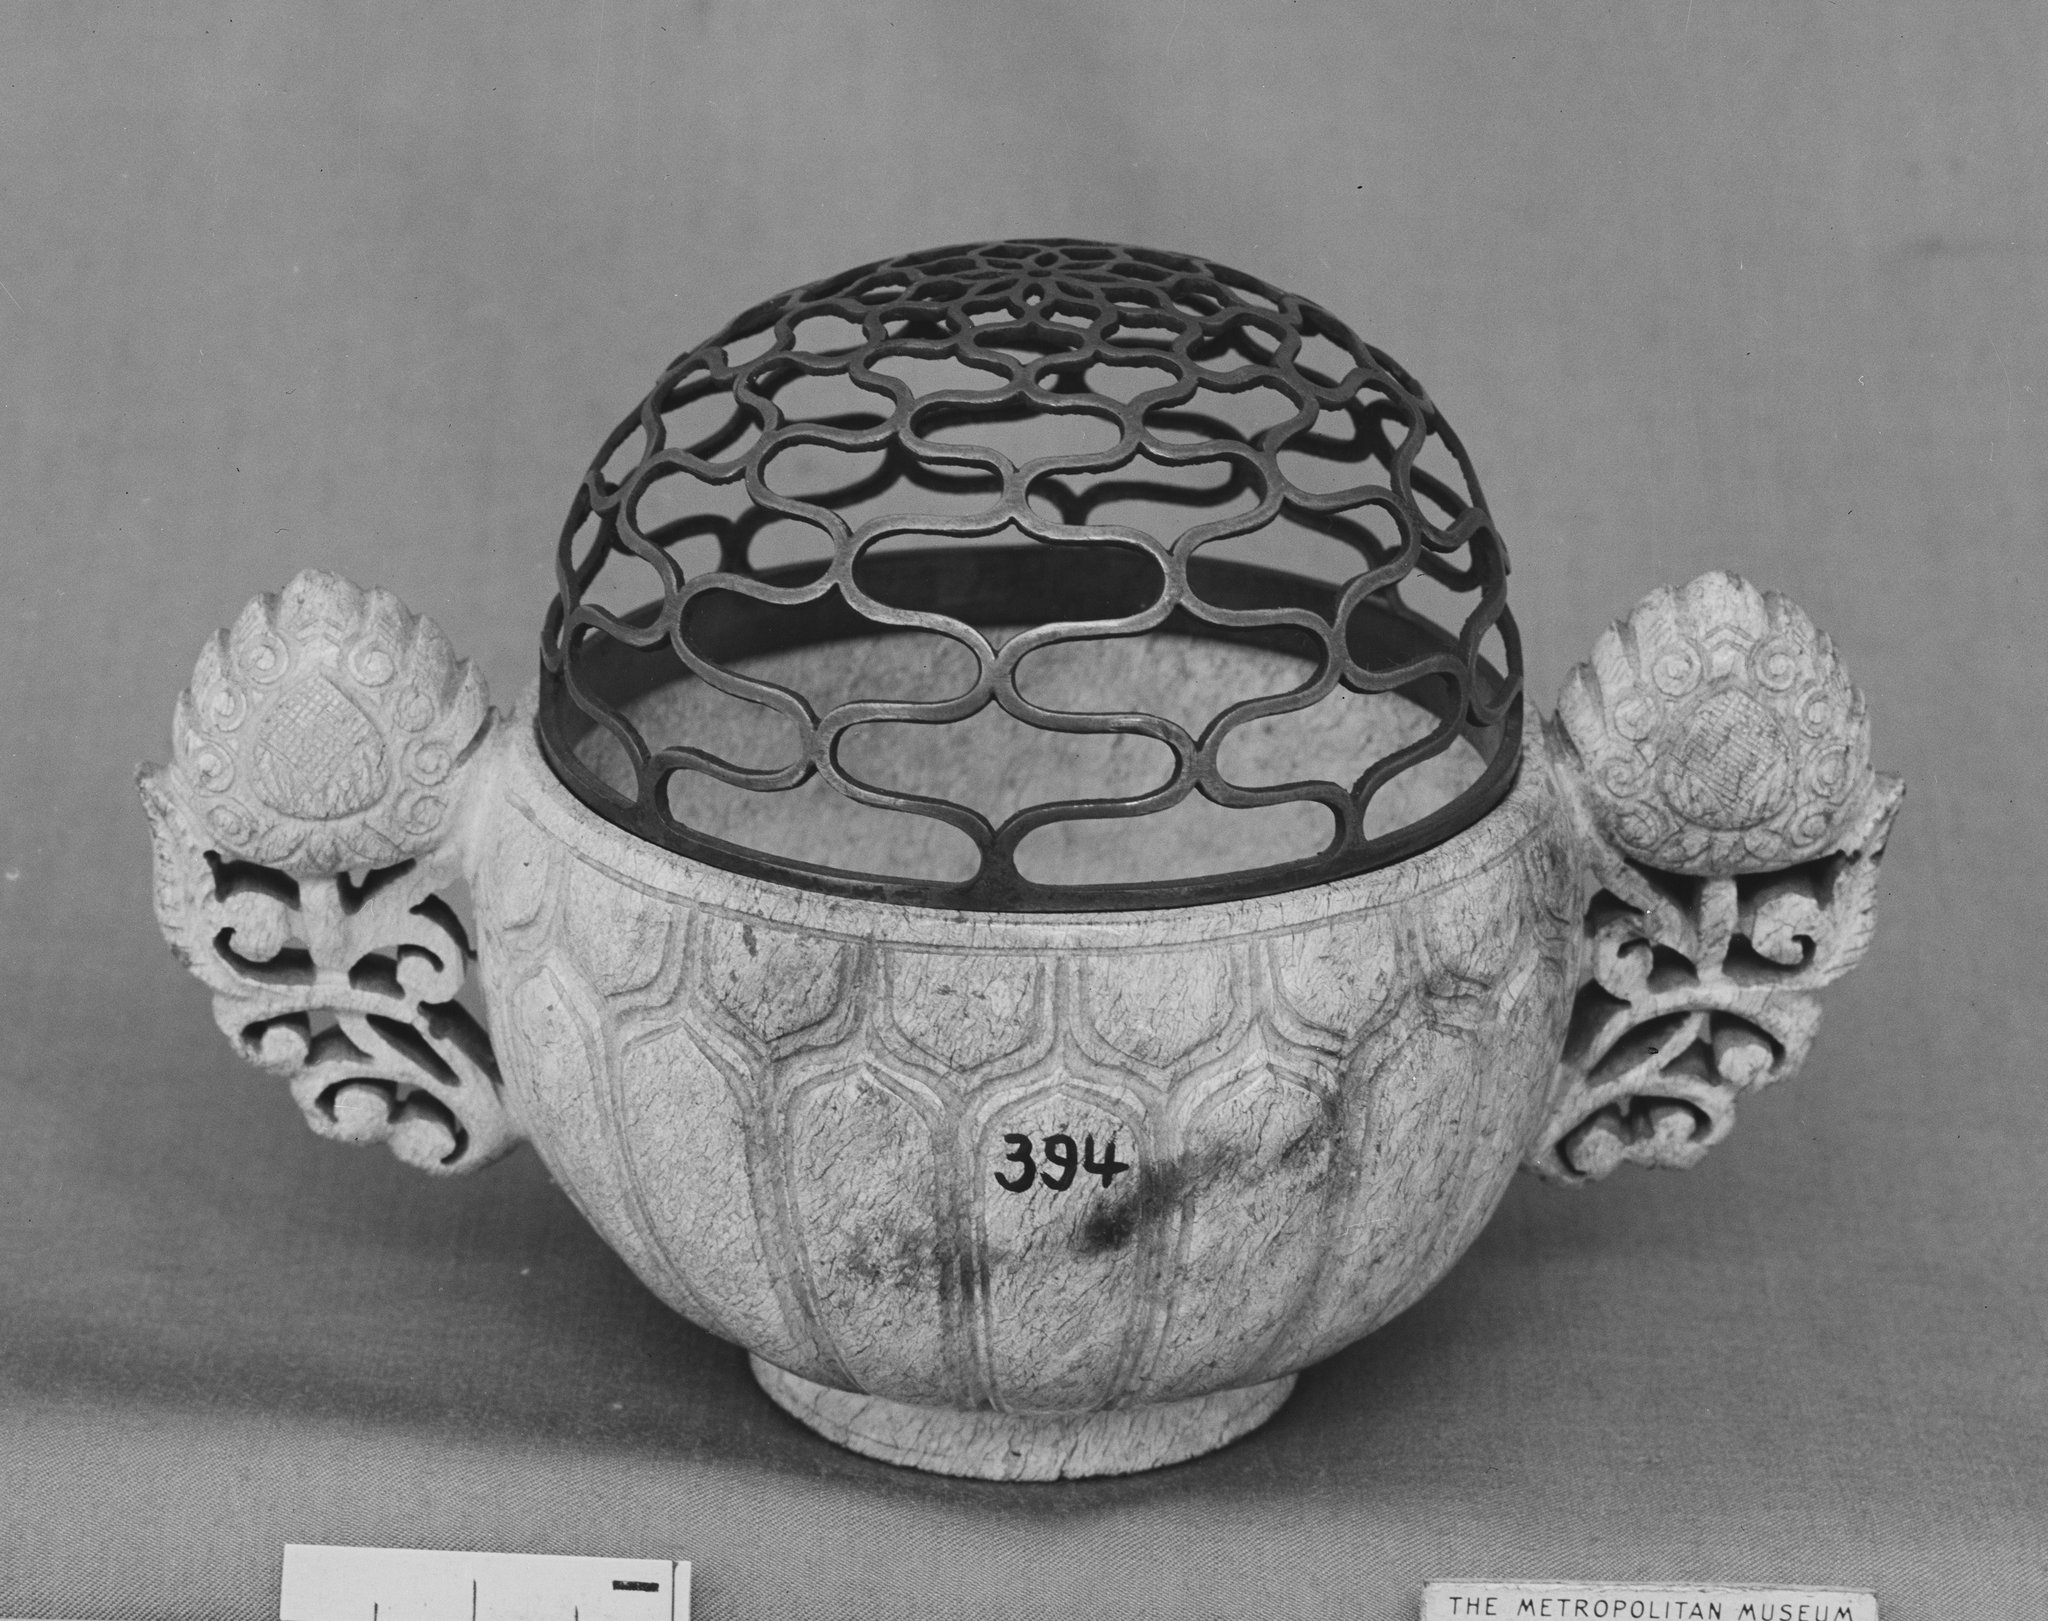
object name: incense burner with cover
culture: chinese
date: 1368-1644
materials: jade